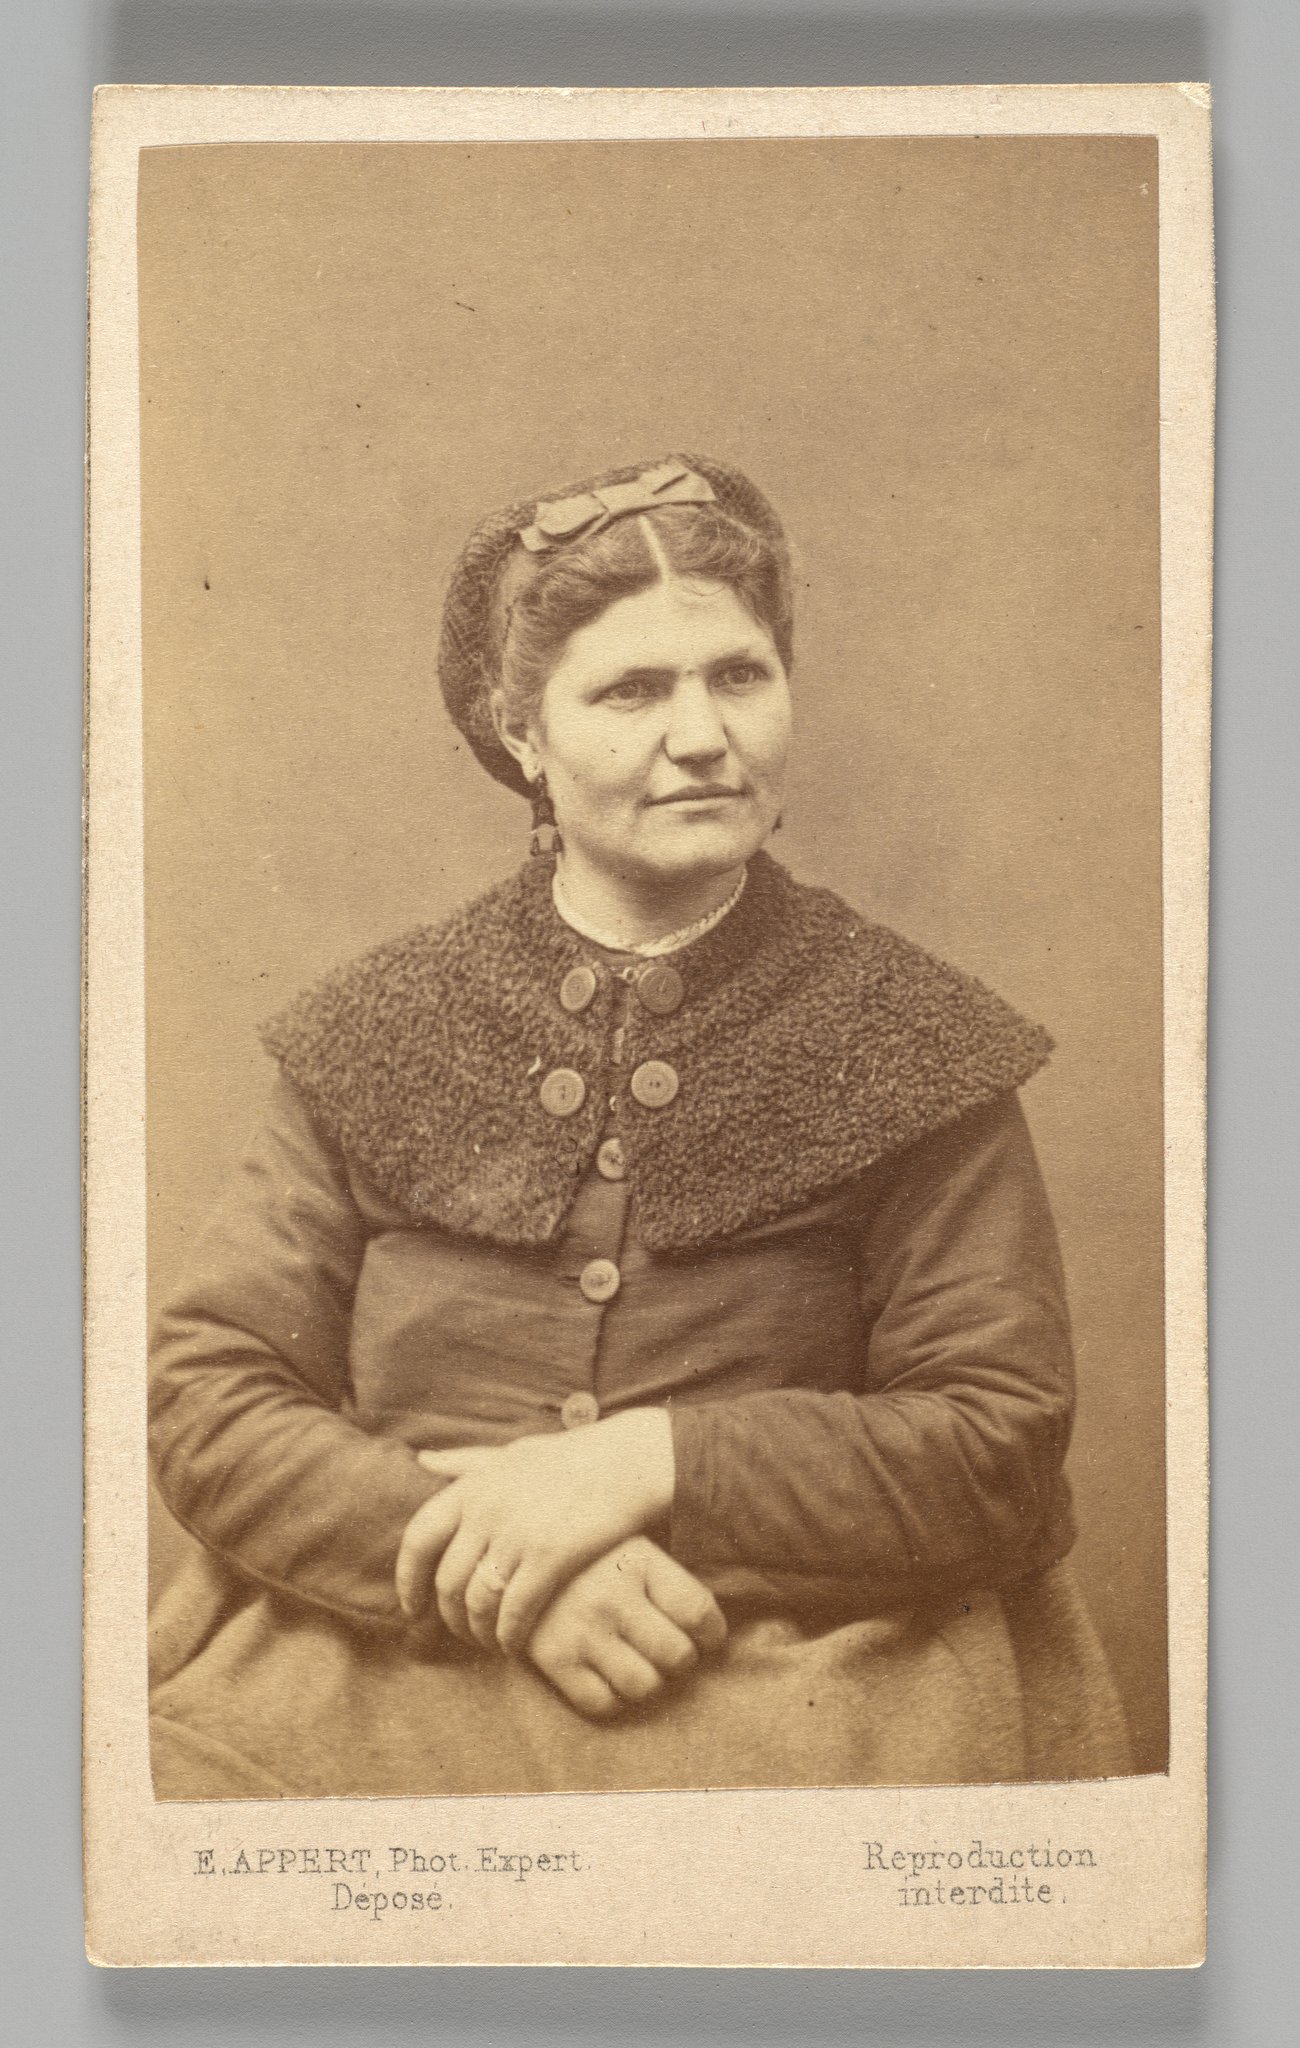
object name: carte de visite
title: [Member of the Paris Commune: Marie Chérel, perpétuité, pillage et incendie]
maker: ernest eugène appert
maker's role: artist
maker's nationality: french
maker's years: 1831-1891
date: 1871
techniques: albumen silver print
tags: portraits,women